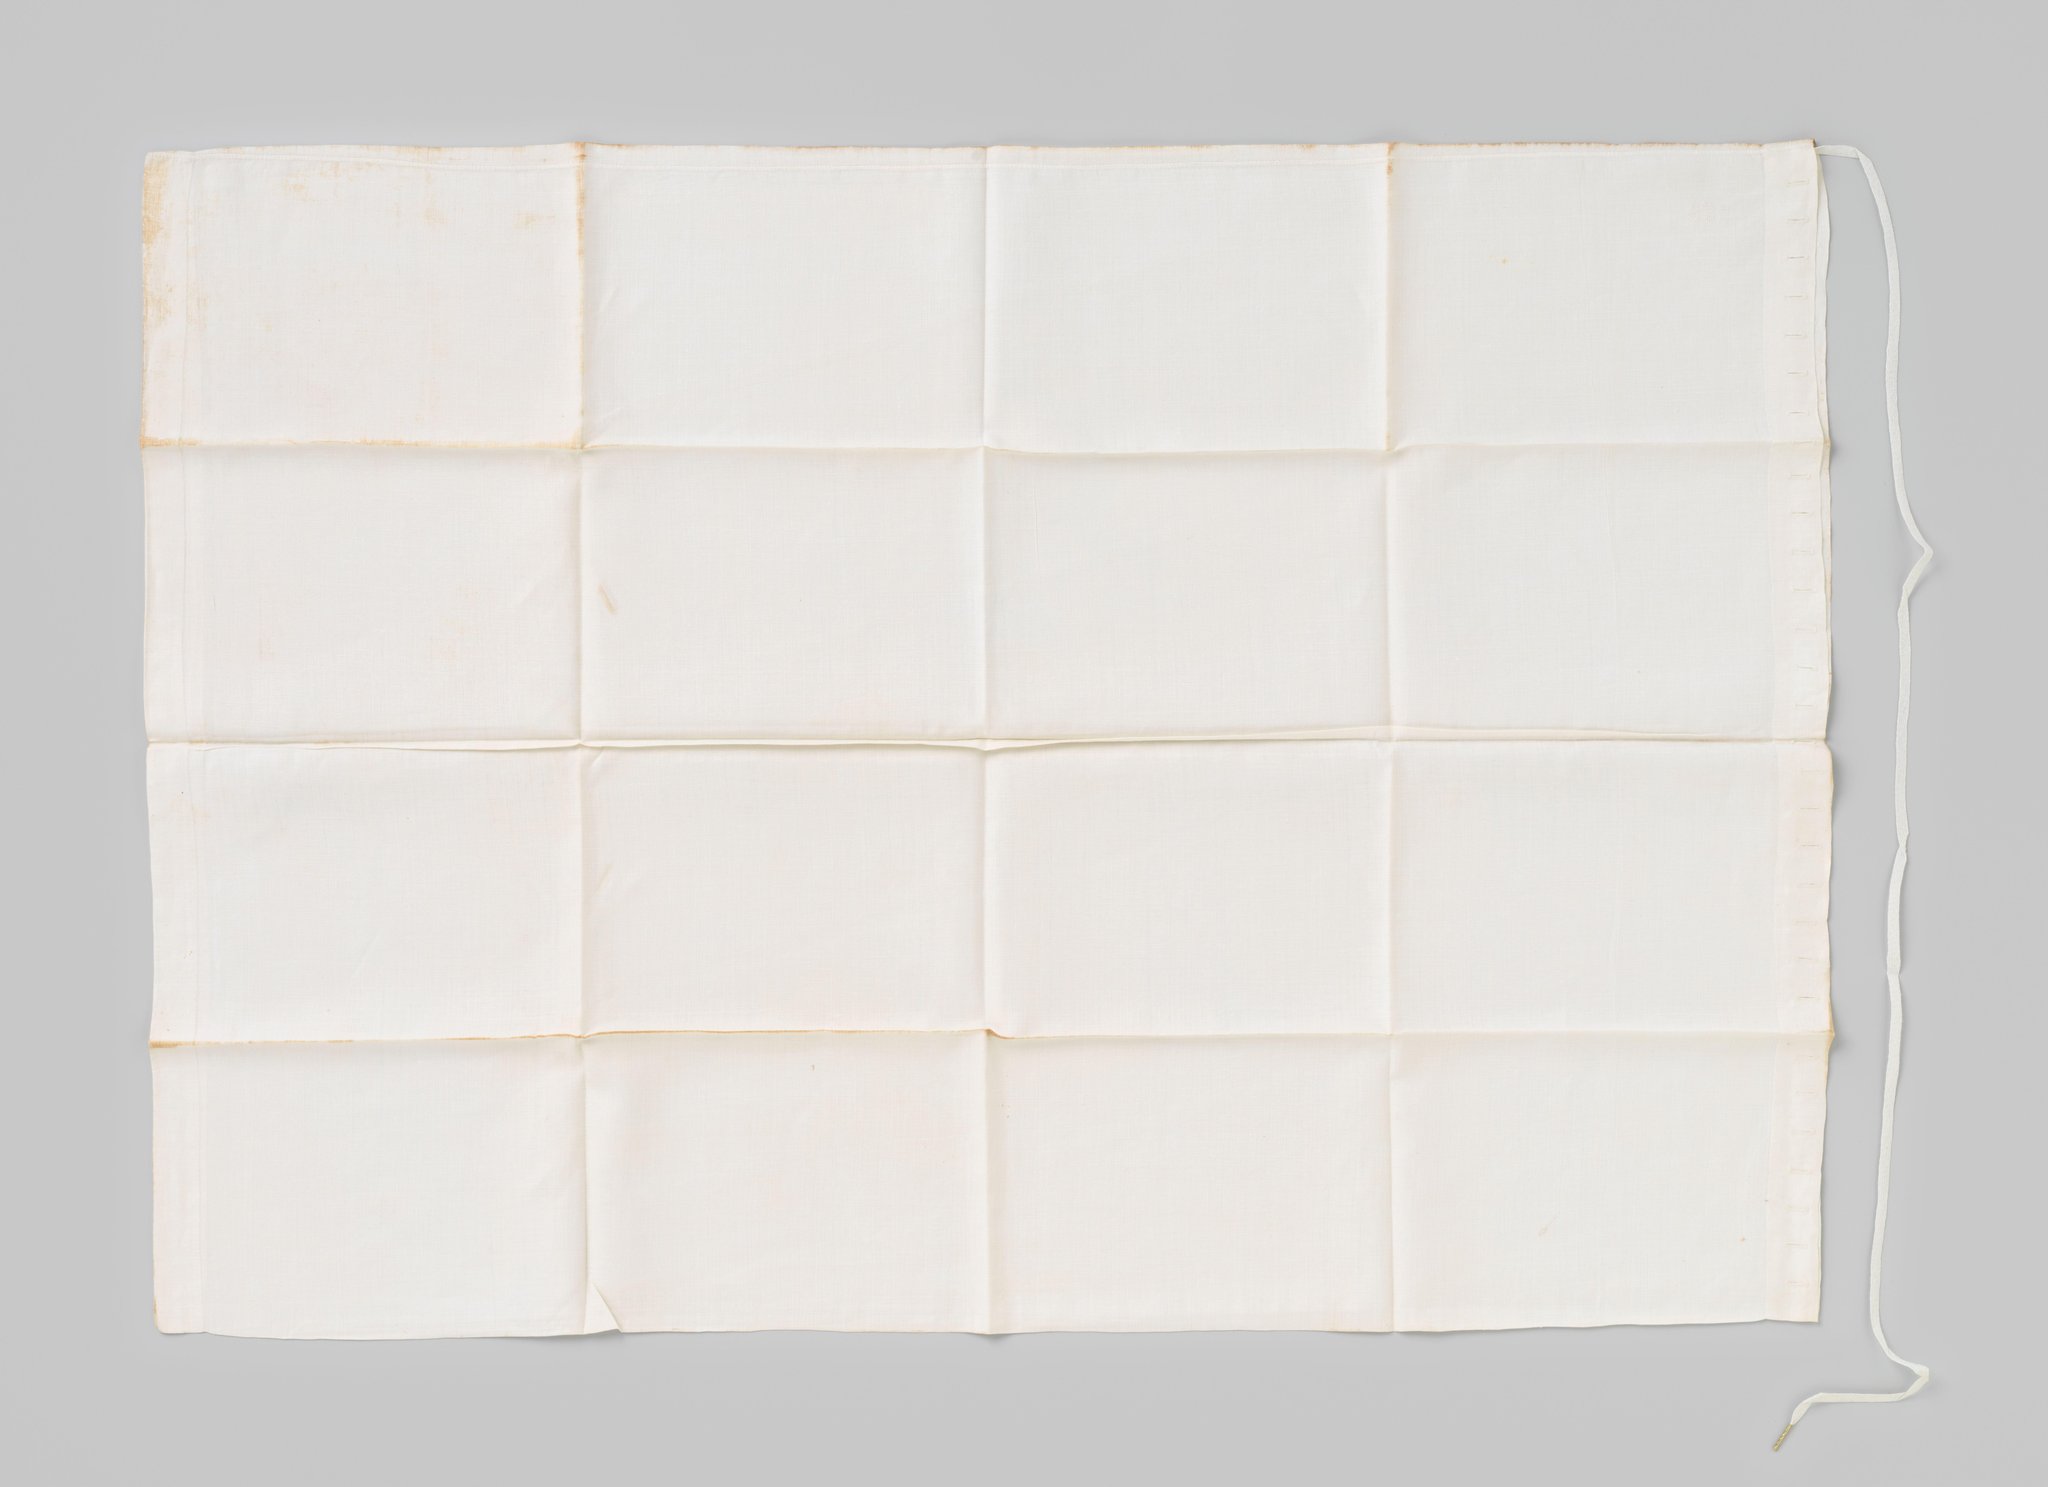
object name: pillowcase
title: Kussensloop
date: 1731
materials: linen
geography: northern netherlands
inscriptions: date: ‘kroon WG 12 1731’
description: Kussensloop van linnen. Gemerkt kroon WG 12 en 1731.